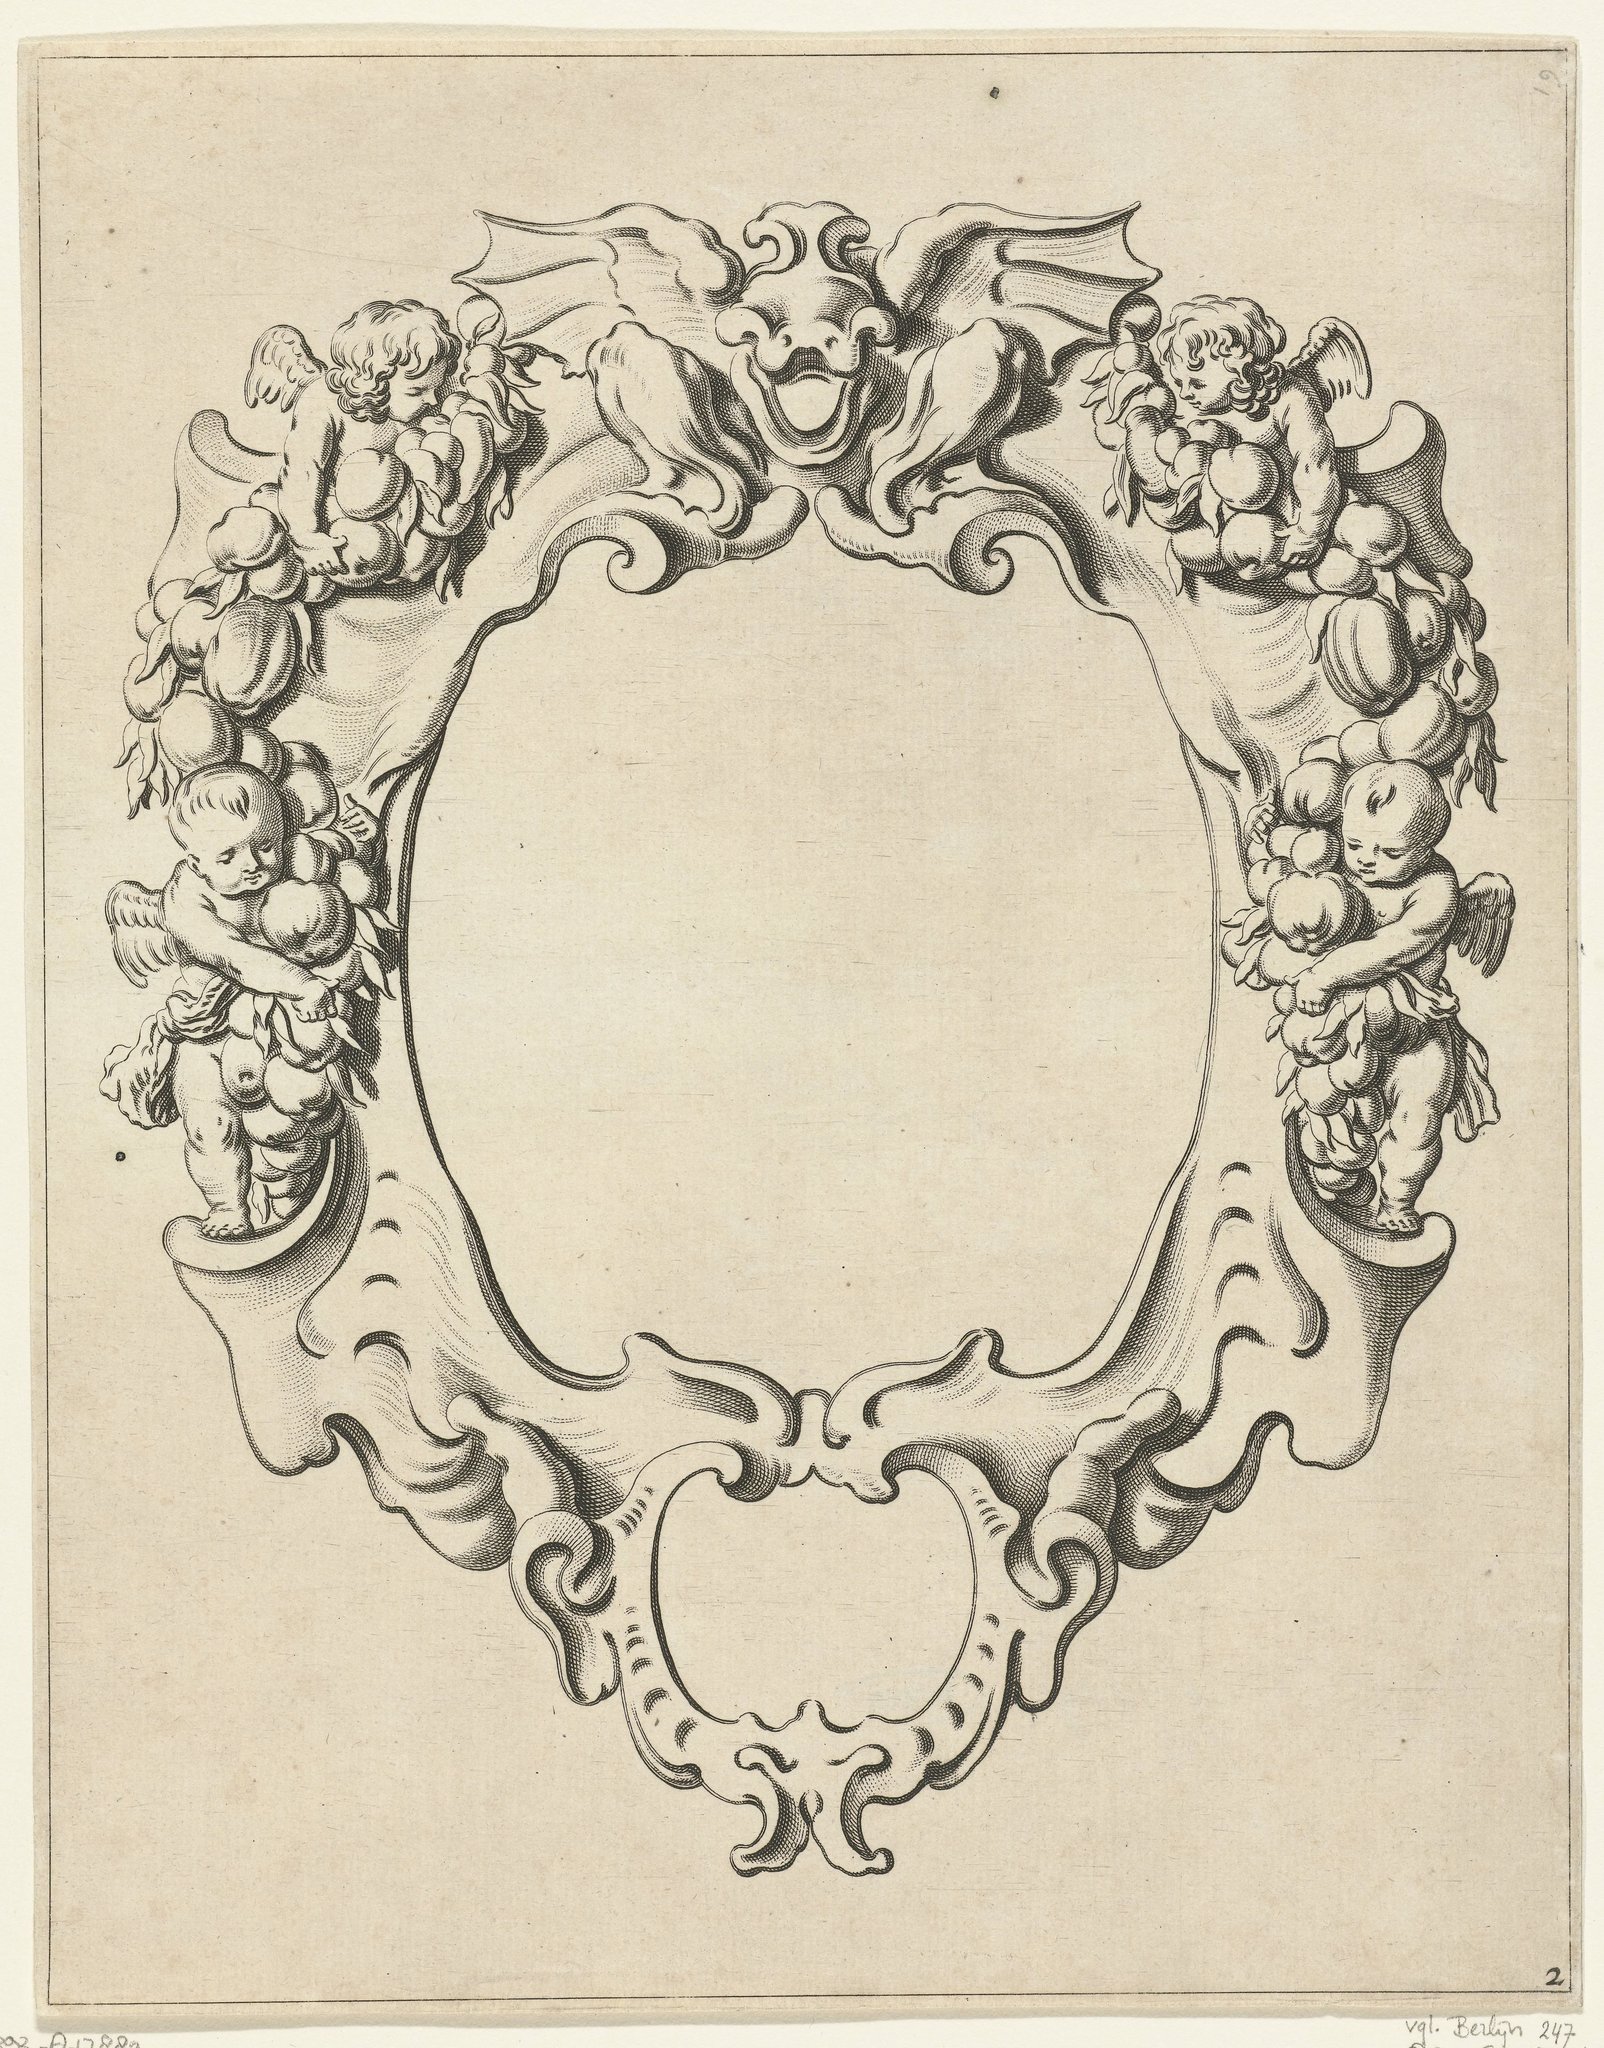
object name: print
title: Cartouche met kwabornament met vier engeltjes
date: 1655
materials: paper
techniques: etching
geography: amsterdam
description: De engeltjes houden een guirlande van fruit vast. Bovenaan zit een gehurkt monster.